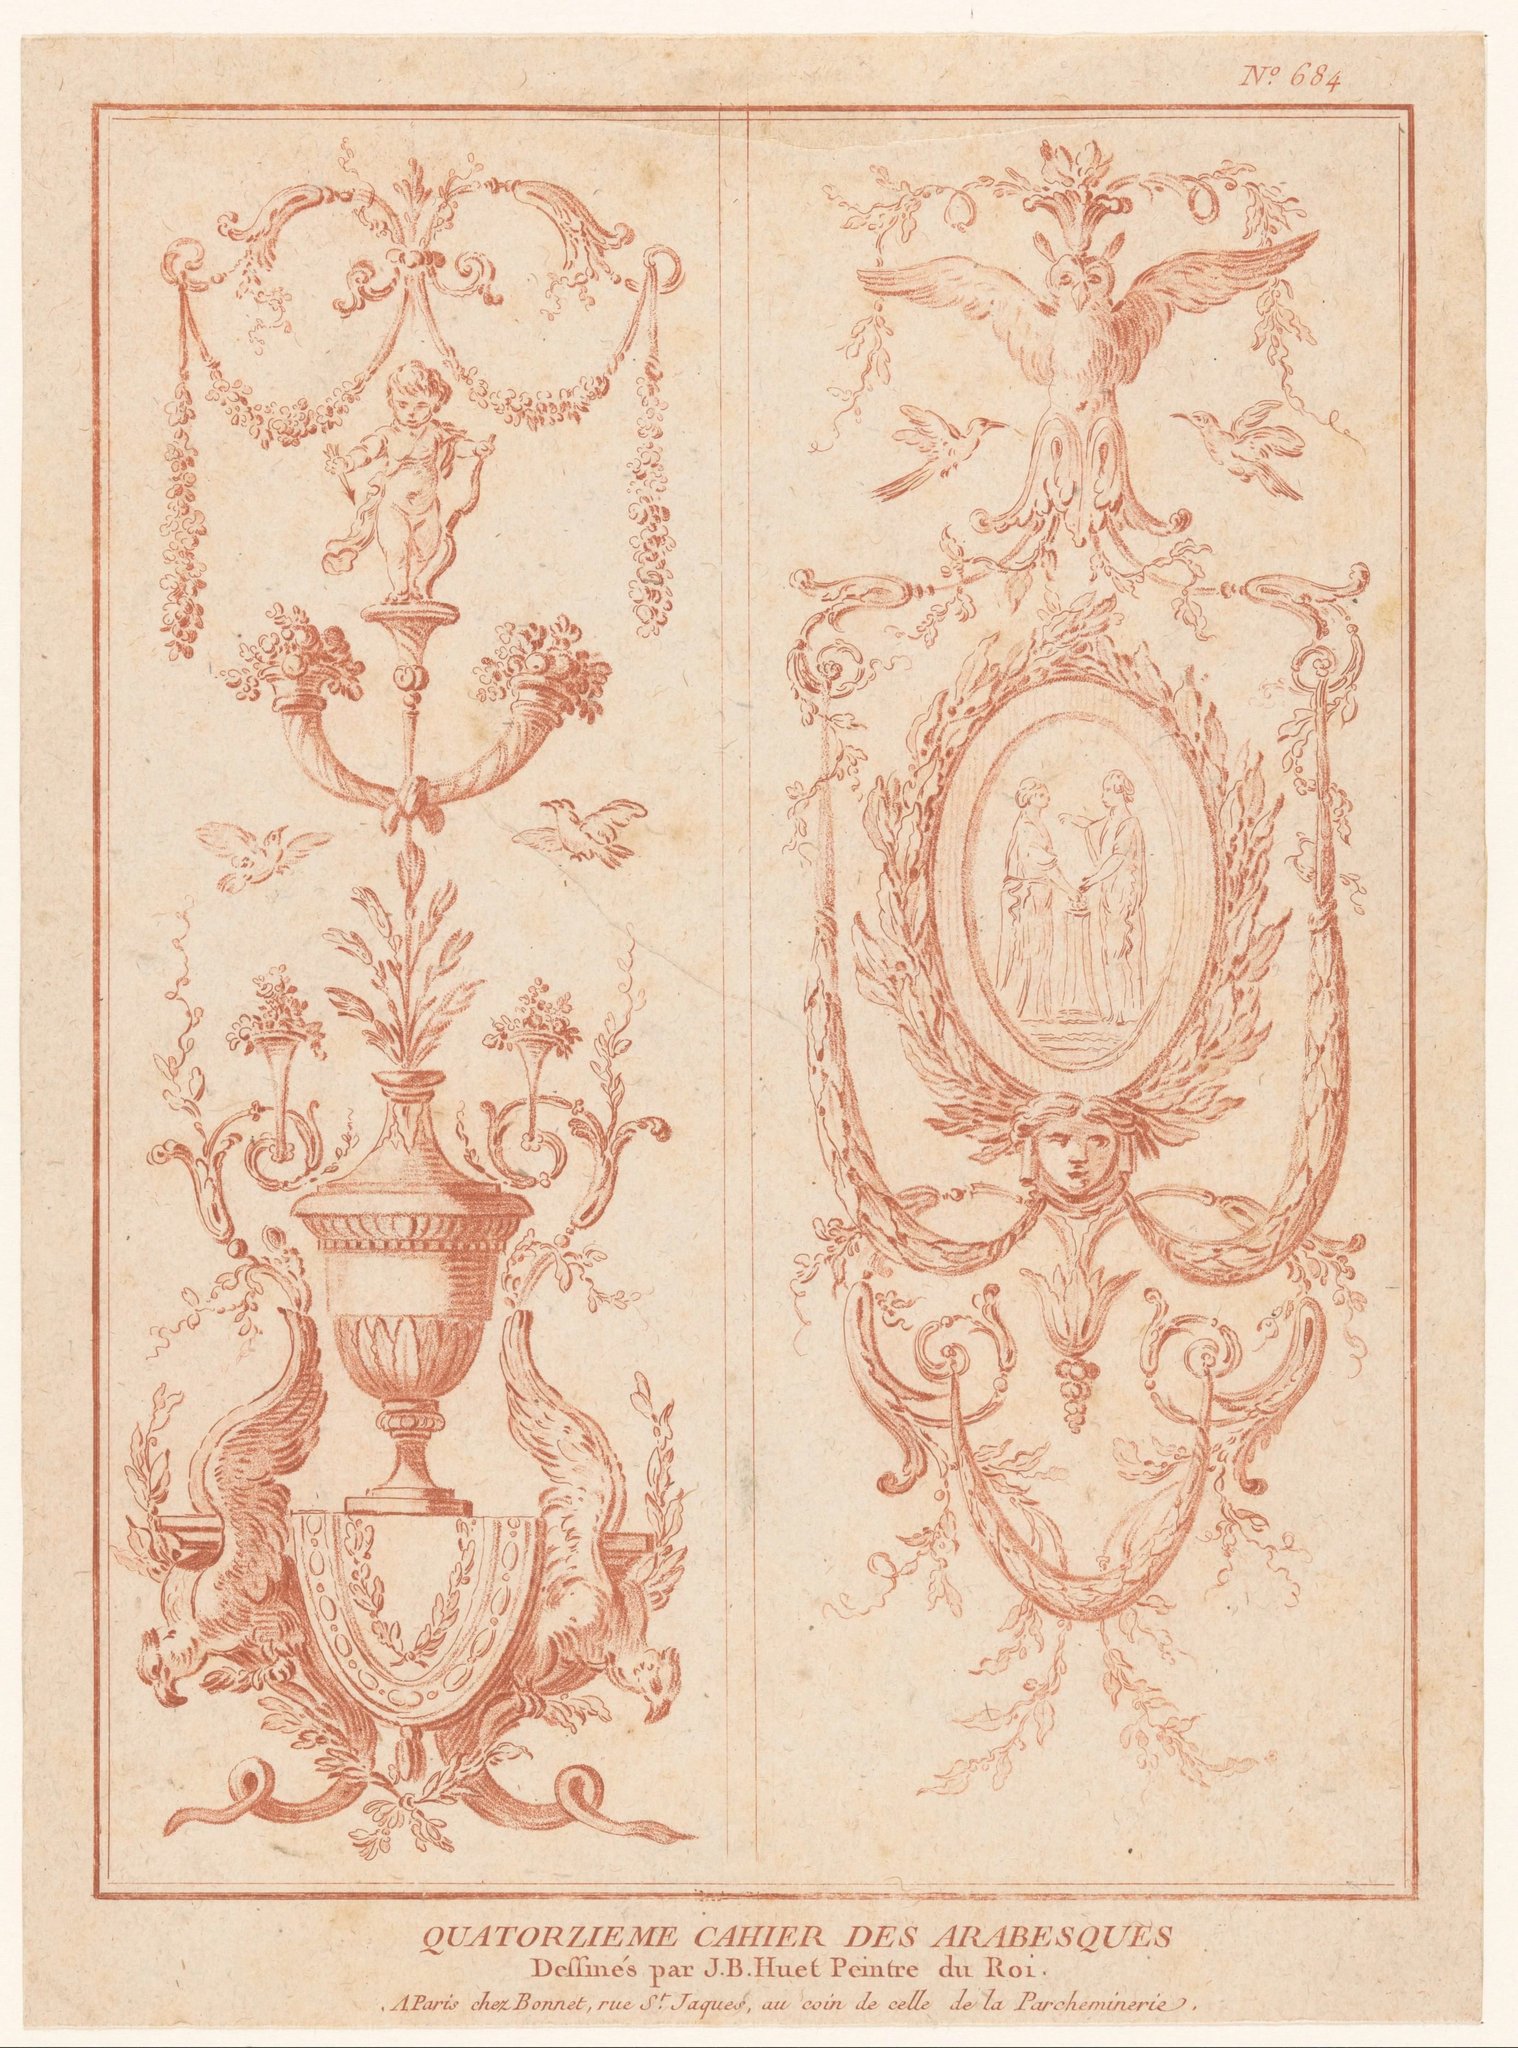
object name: ornament print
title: Quatorzieme Cahier des Arabesques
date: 1770-1780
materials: paper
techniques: printmaking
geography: paris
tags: ornament ~ arabesque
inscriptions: collector's mark: Lugt 2228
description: Twee panelen met arabesken. Links met een vaas op voetstuk met twee hanen, daarboven hoornen des overvloeds en een putto onder guirlandes. Rechts een ovaal medaillon met twee figuren, omgeven door arabesken en aan de bovenzijde een uil. Uitgeversnummer 684.